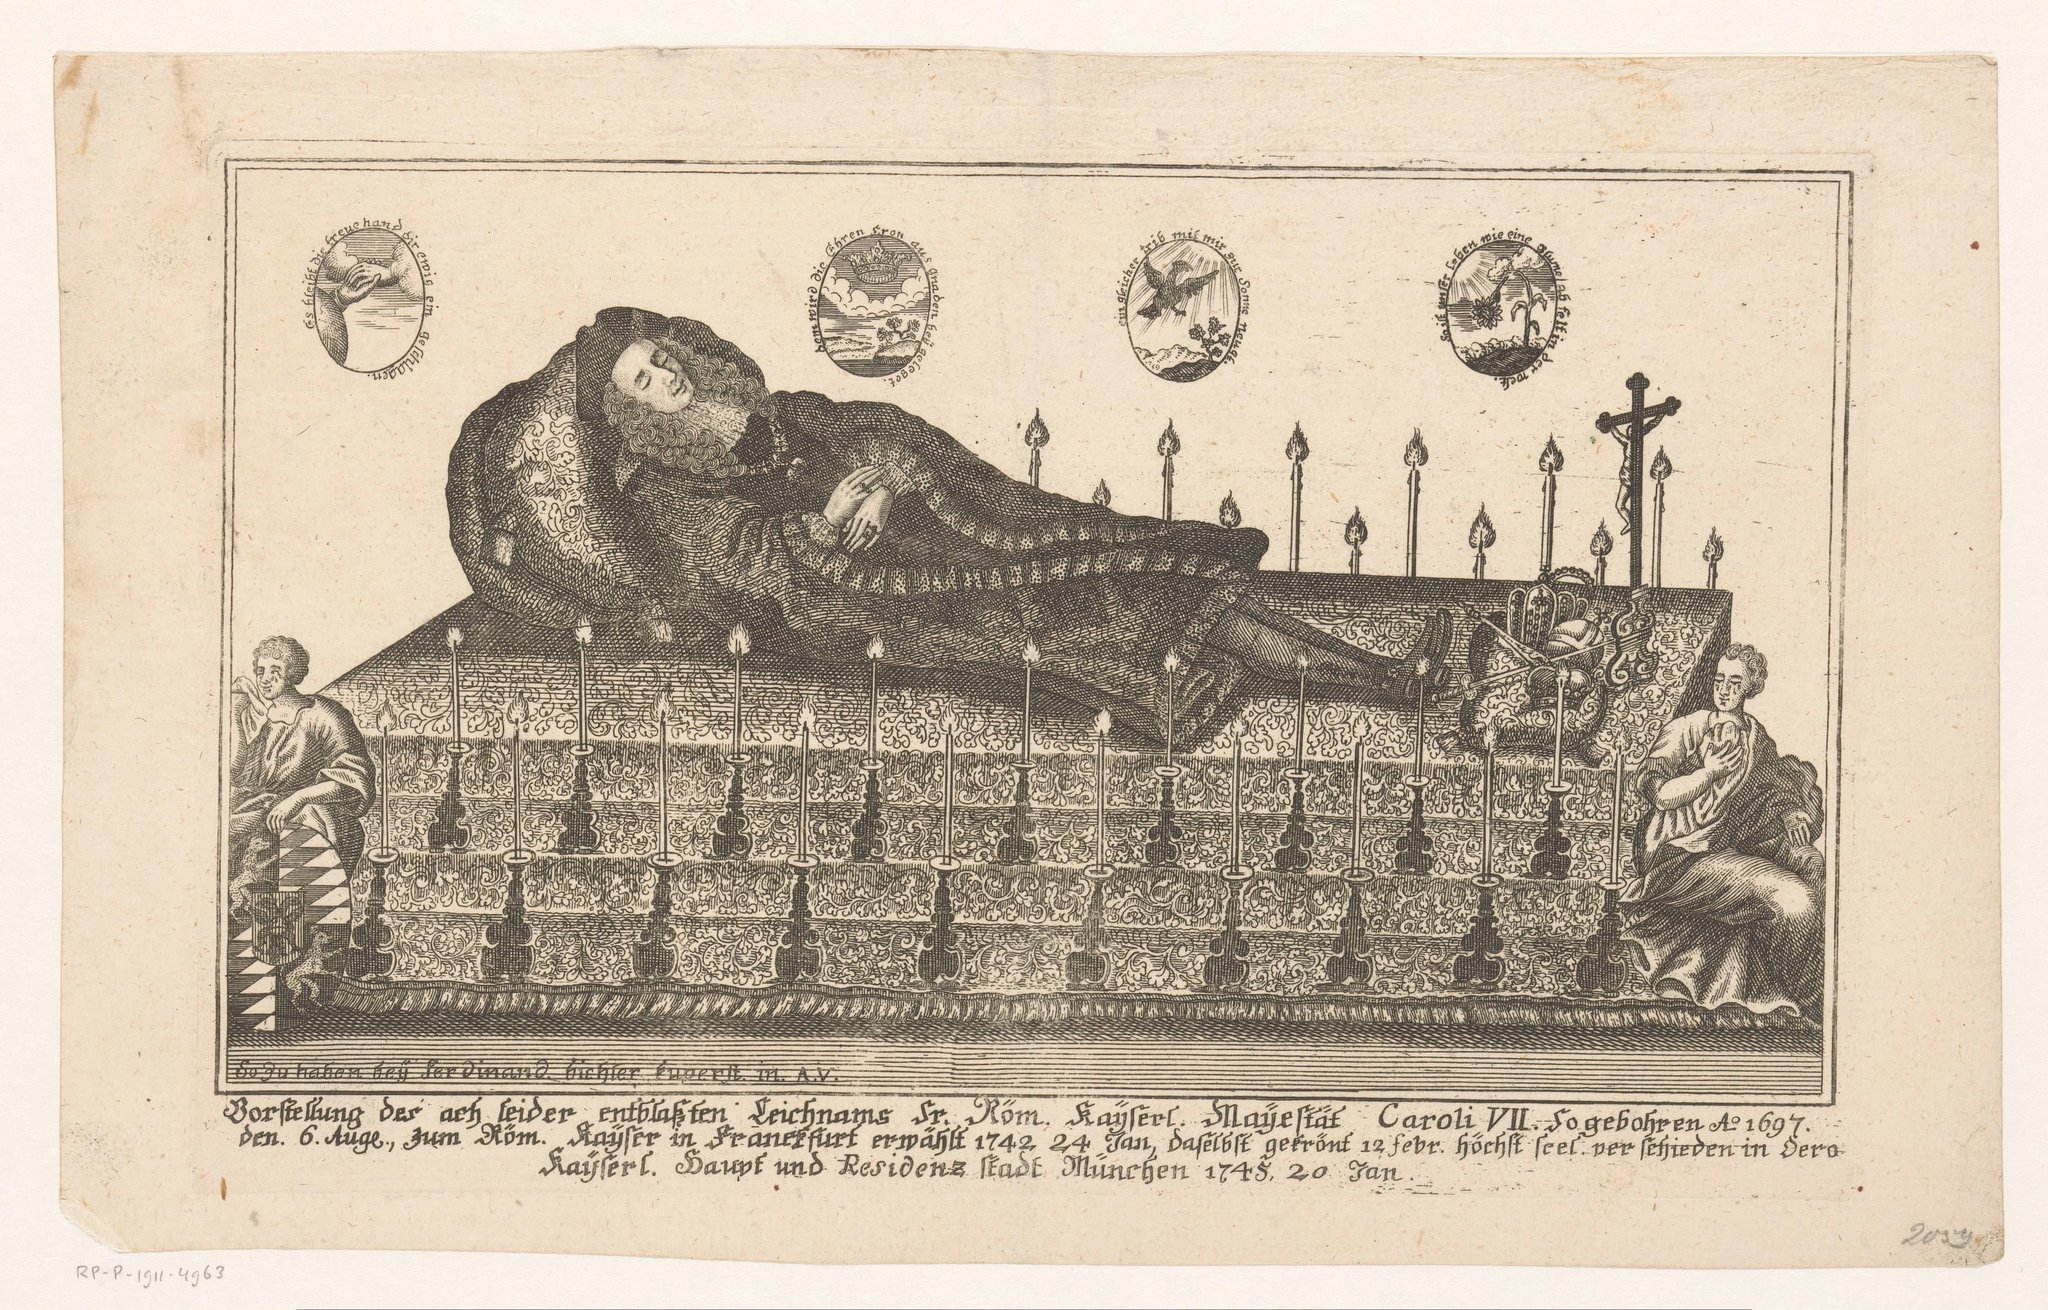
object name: print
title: Portret van Rooms-Duits keizer Karel VII Albrecht op zijn paradebed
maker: ferdinand bichler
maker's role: print maker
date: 1745-1747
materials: paper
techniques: etching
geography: augsburg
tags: brussels, karel vii albrecht (duits keizer), 'pleurants', historial persons (+ death-portrait), crucifix ~ personal devotion, lying in state, armorial bearing, heraldry, insignia and symbols of sovereignty (crown, diadem, sceptre, orb, seal, standard, cloak, pectoral)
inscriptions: collector's mark: Lugt 2228